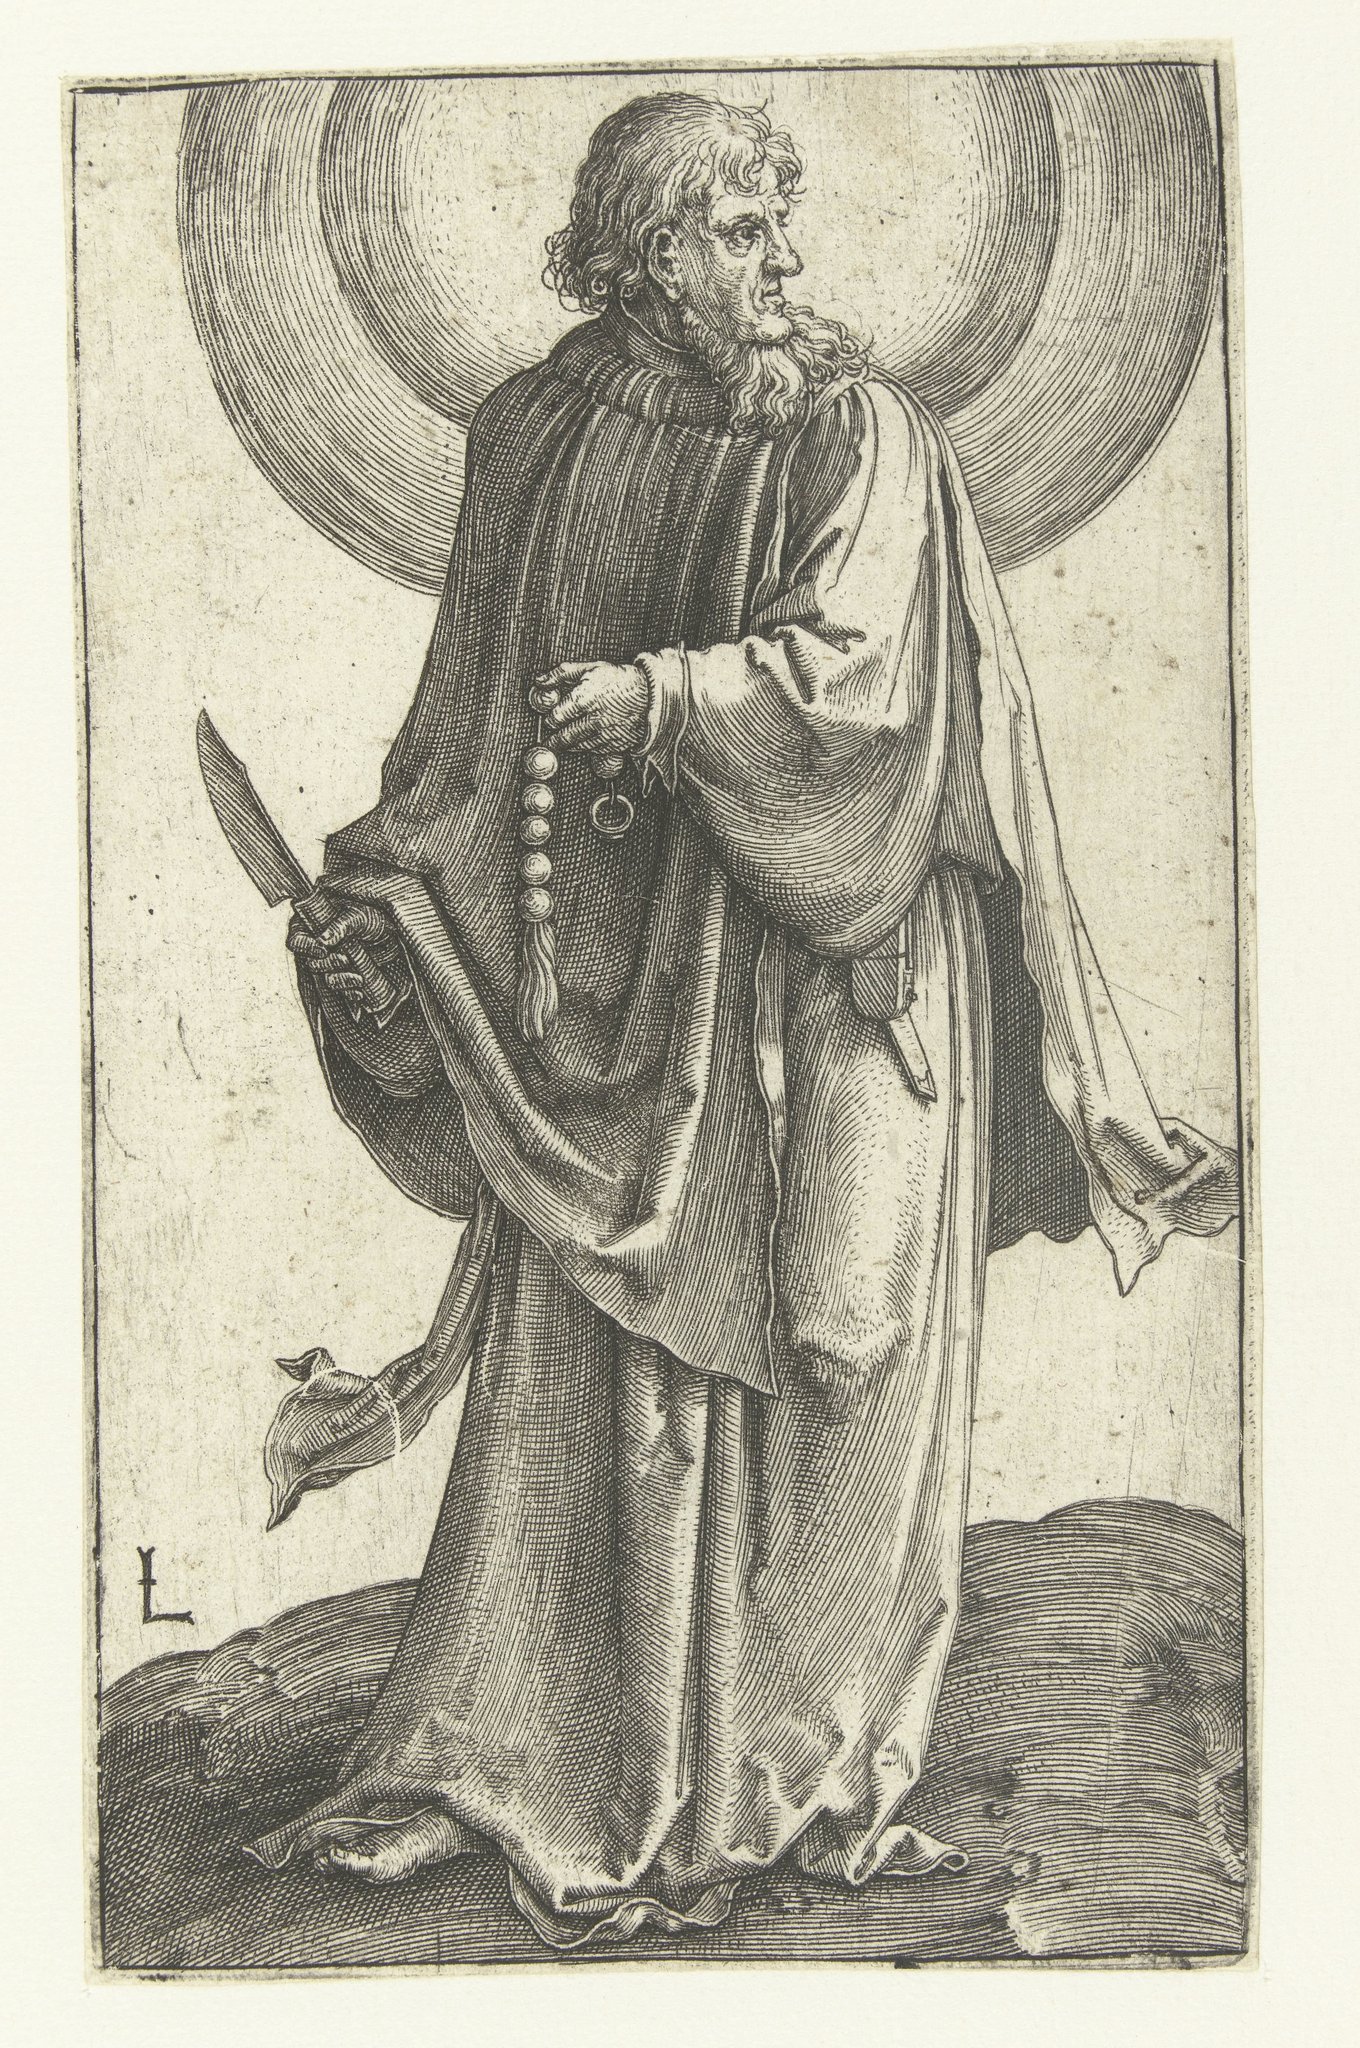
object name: print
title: Christus en de apostelen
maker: lucas van leyden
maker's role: draughtsman, painter, print maker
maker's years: 1494-1533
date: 1508-1512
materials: paper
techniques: engraving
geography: low countries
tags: the apostle bartholomew; possible attributes: book, devil or dragon at feet, knife, scroll, flayed skin, staff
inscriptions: collector's mark: Lugt 2228a